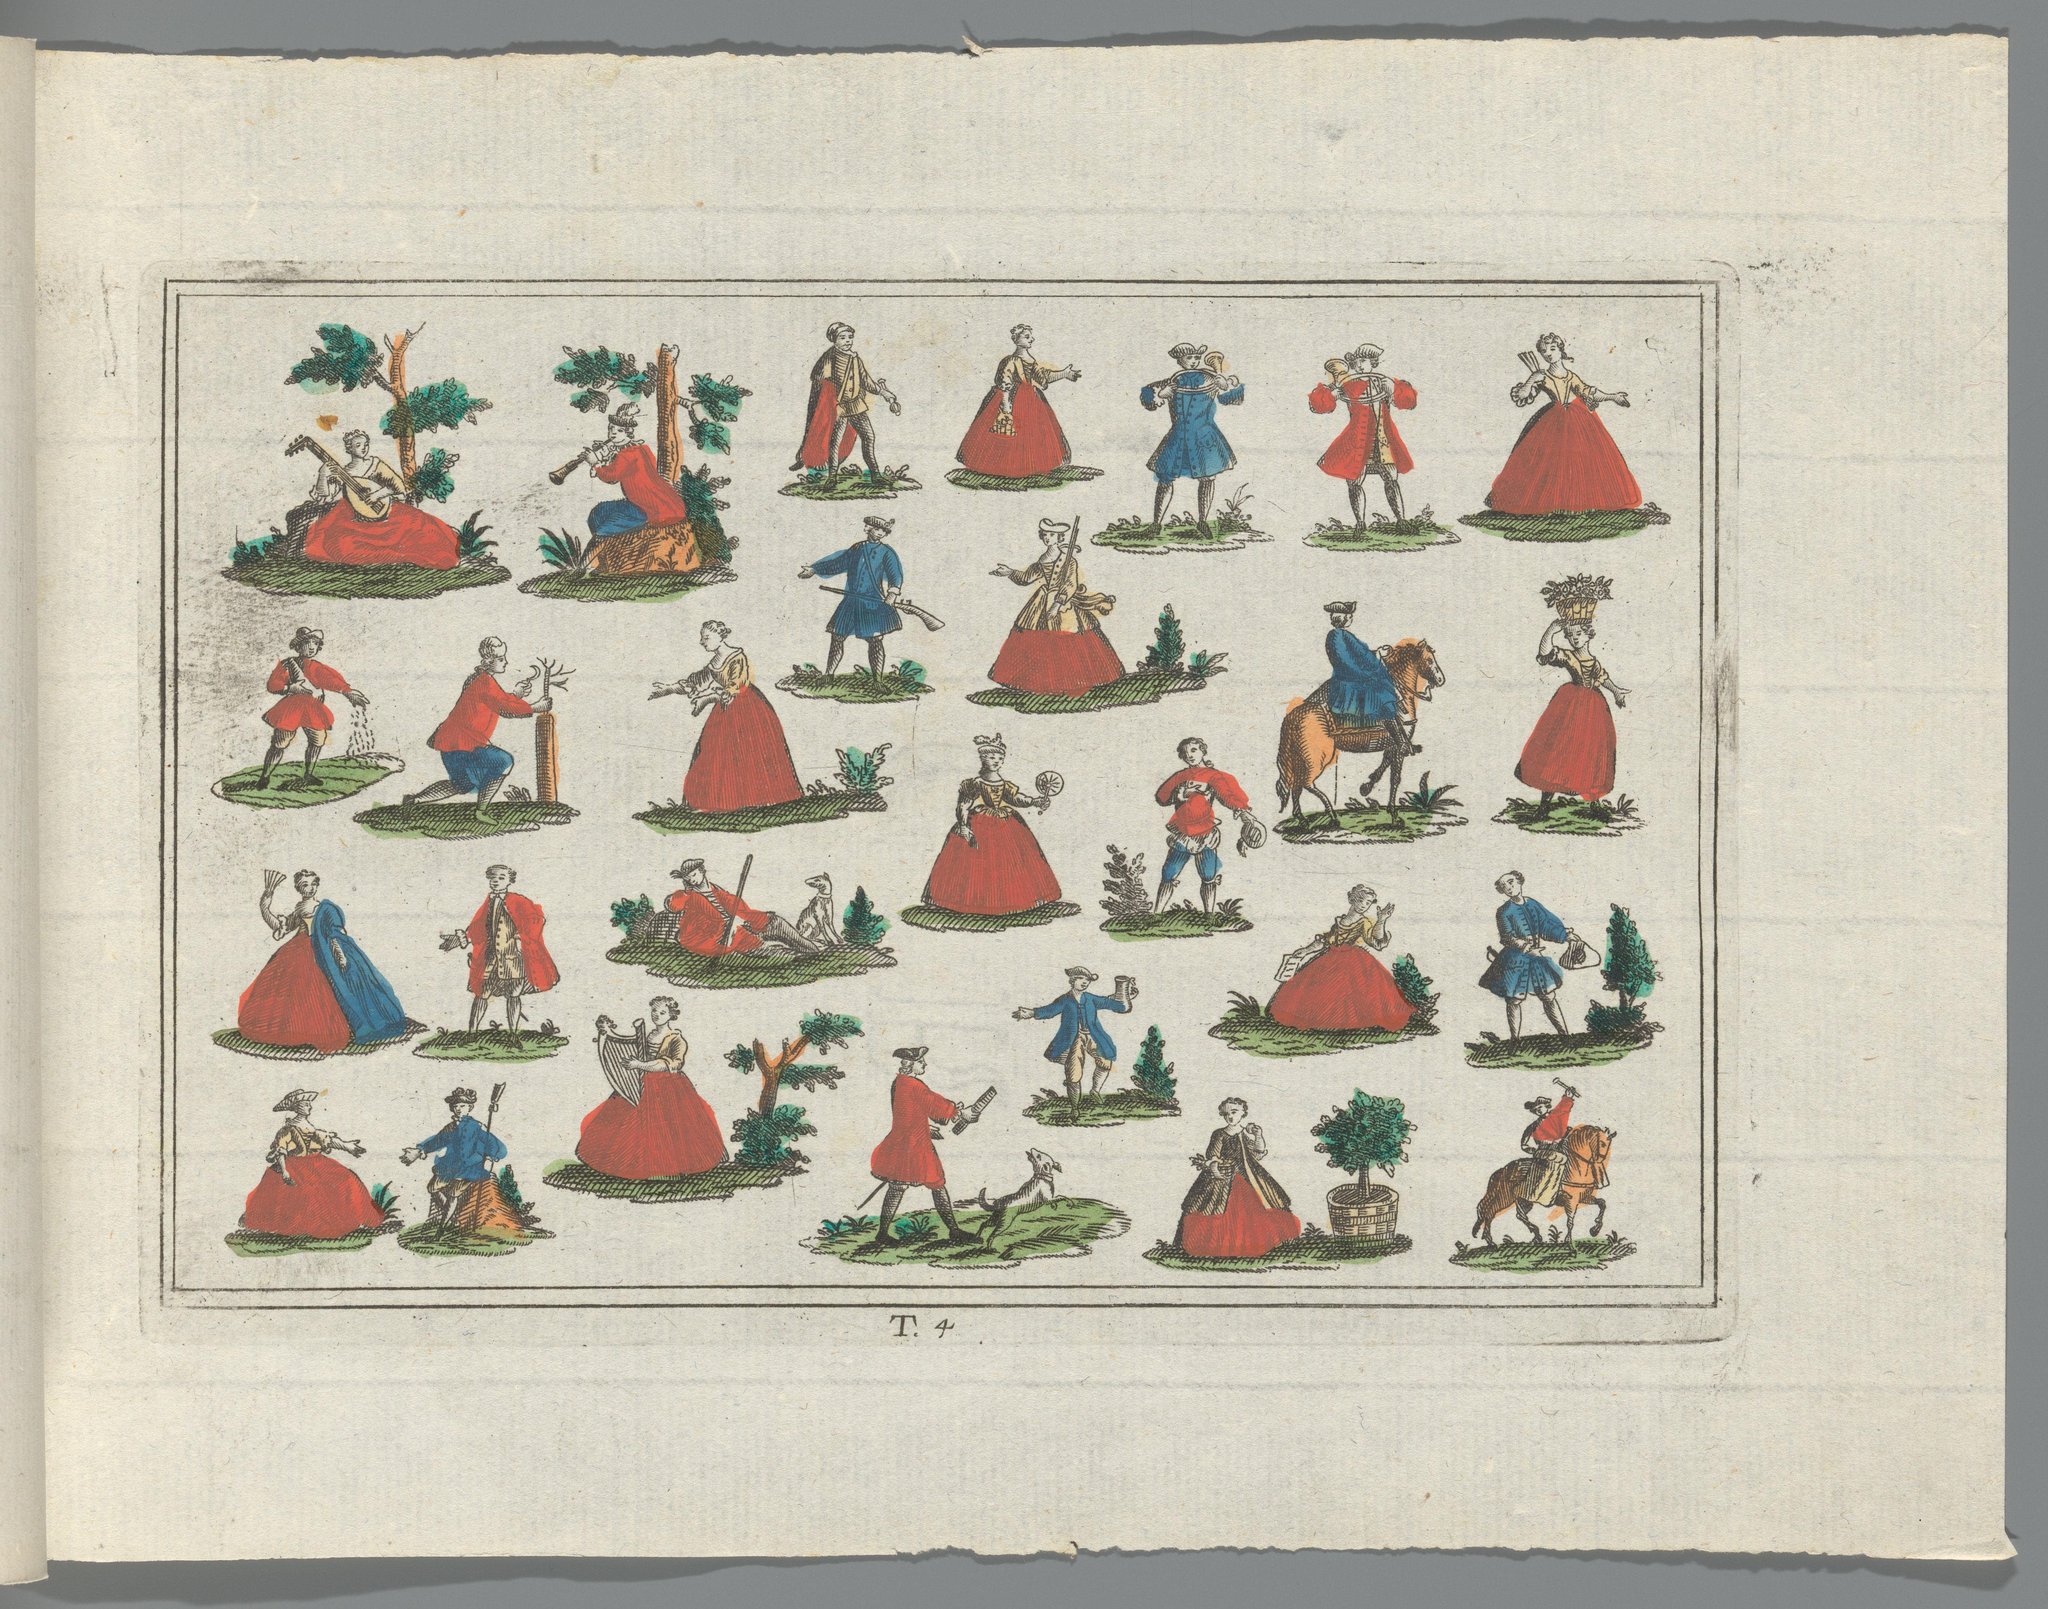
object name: print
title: Bladen met knipplaatjes en decoratieve randen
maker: Anonymous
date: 1750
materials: paper, watercolor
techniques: etching, hand coloring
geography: paris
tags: adult woman, adult man, clothes, costume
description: Blad met galante dames en heren, in verschillende bezigheden. Midden onder genummerd: T. 4. Een van 39 bladen met knipplaatjes en decoratieve randen.